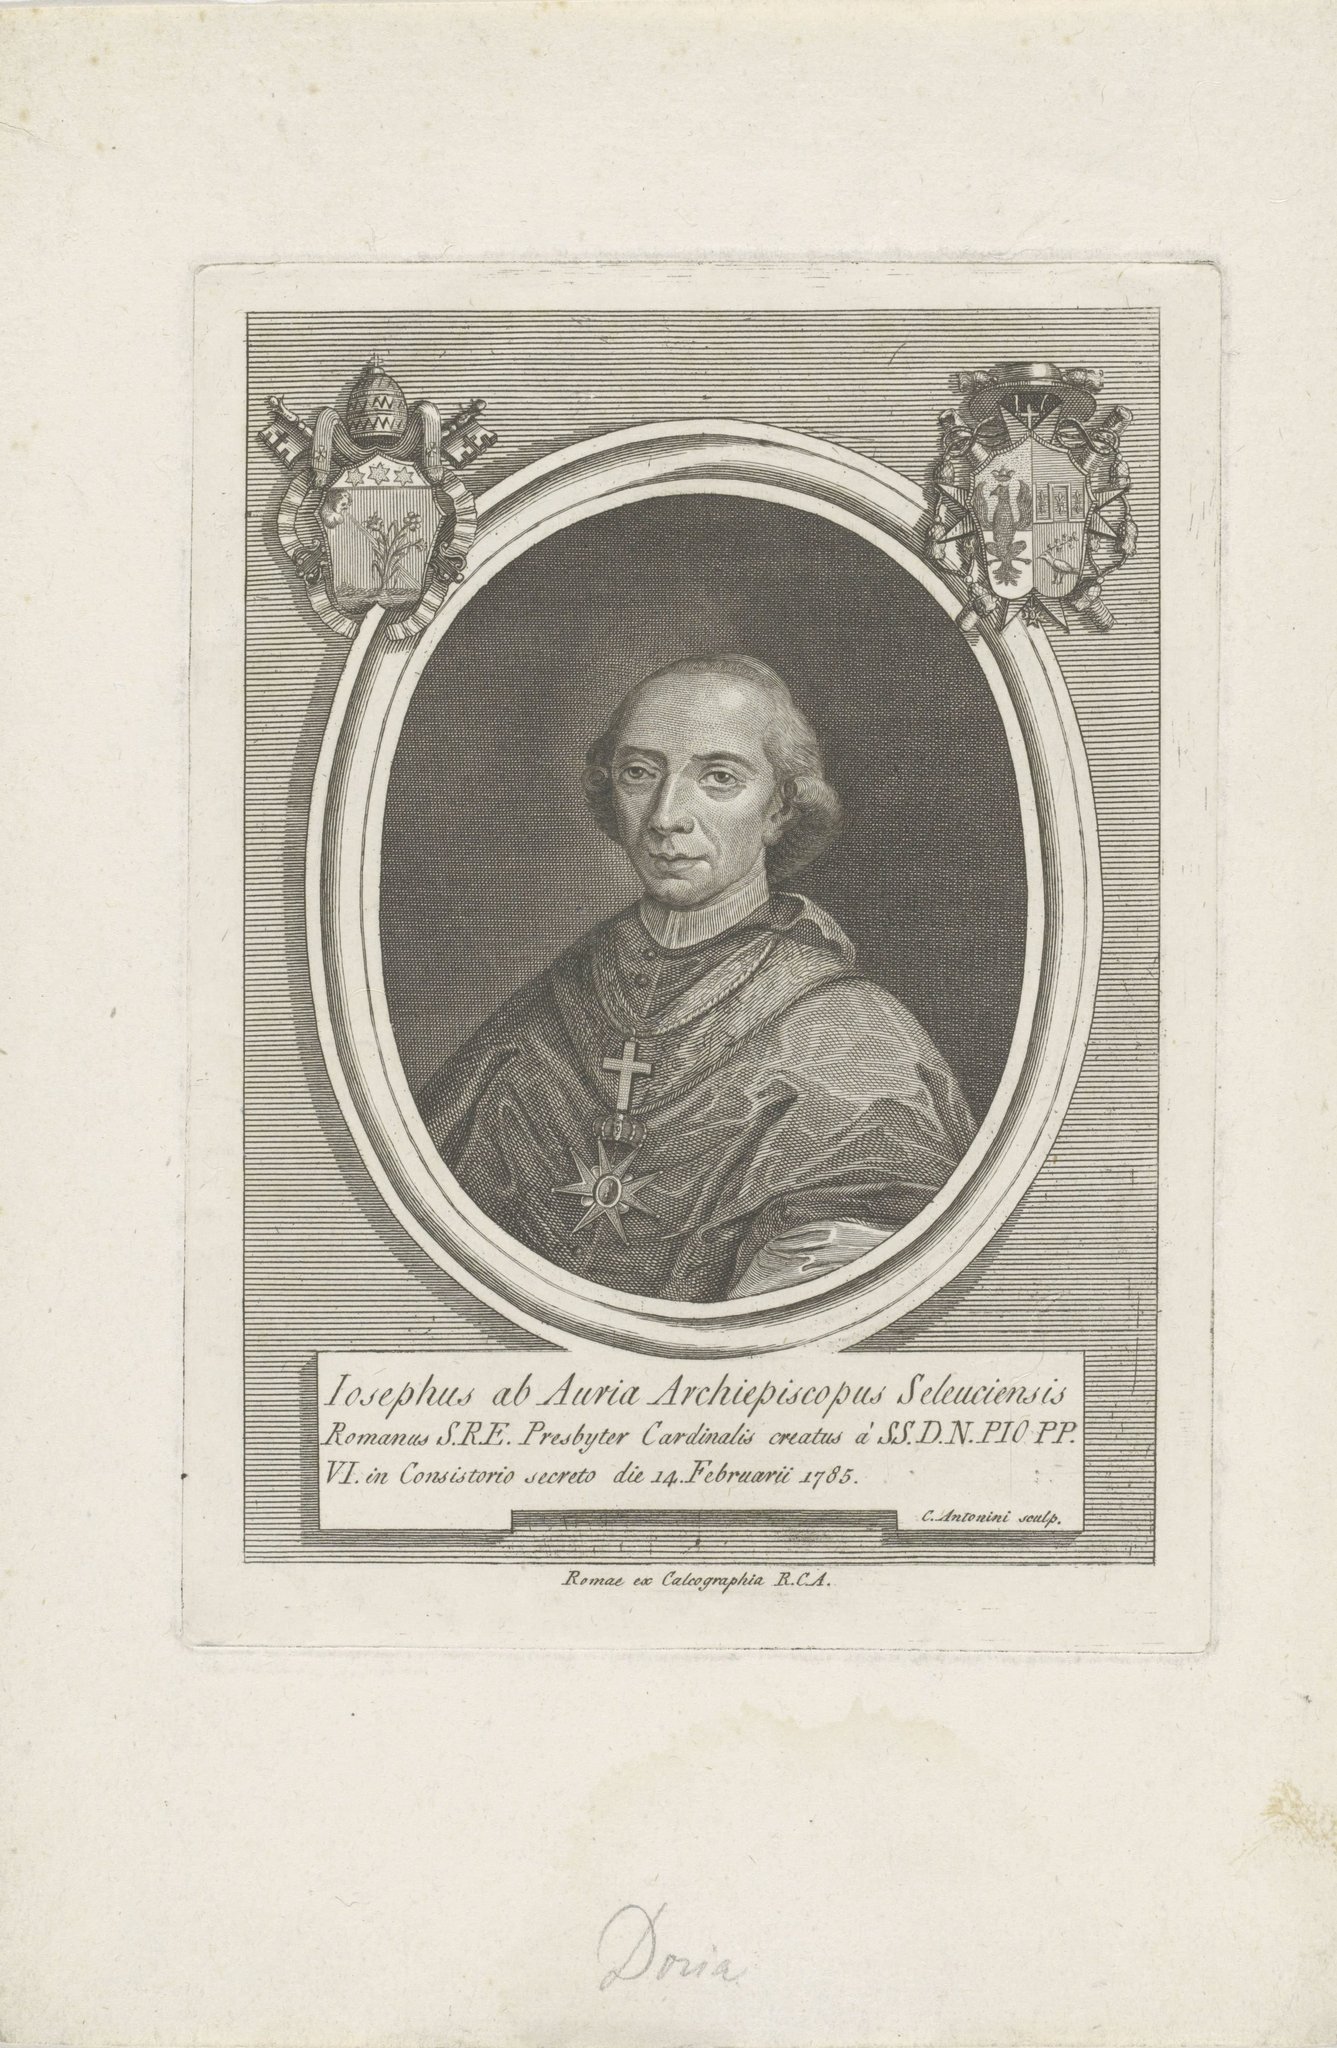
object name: print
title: Portretten van kardinalen met twee wapenschilden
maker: carlo antonini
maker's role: print maker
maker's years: 1749-1835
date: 1795-1805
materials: paper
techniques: engraving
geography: italy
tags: clergyman, cardinal, historical persons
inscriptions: collector's mark: Lugt 2228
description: Prent uit een reeks van onbekende omvang met portretten van kardinalen. De prenten werden vanaf 1657 vervaardigd in opdracht van uitgever Giovanni Giacomo de’ Rossi, waarna de productie werd voortgezet onder leiding van zijn opvolgers Domenico de’ Rossi en Lorenzo Filippo de’ Rossi, en tenslotte onder leiding van de Calcographia R.C.A.